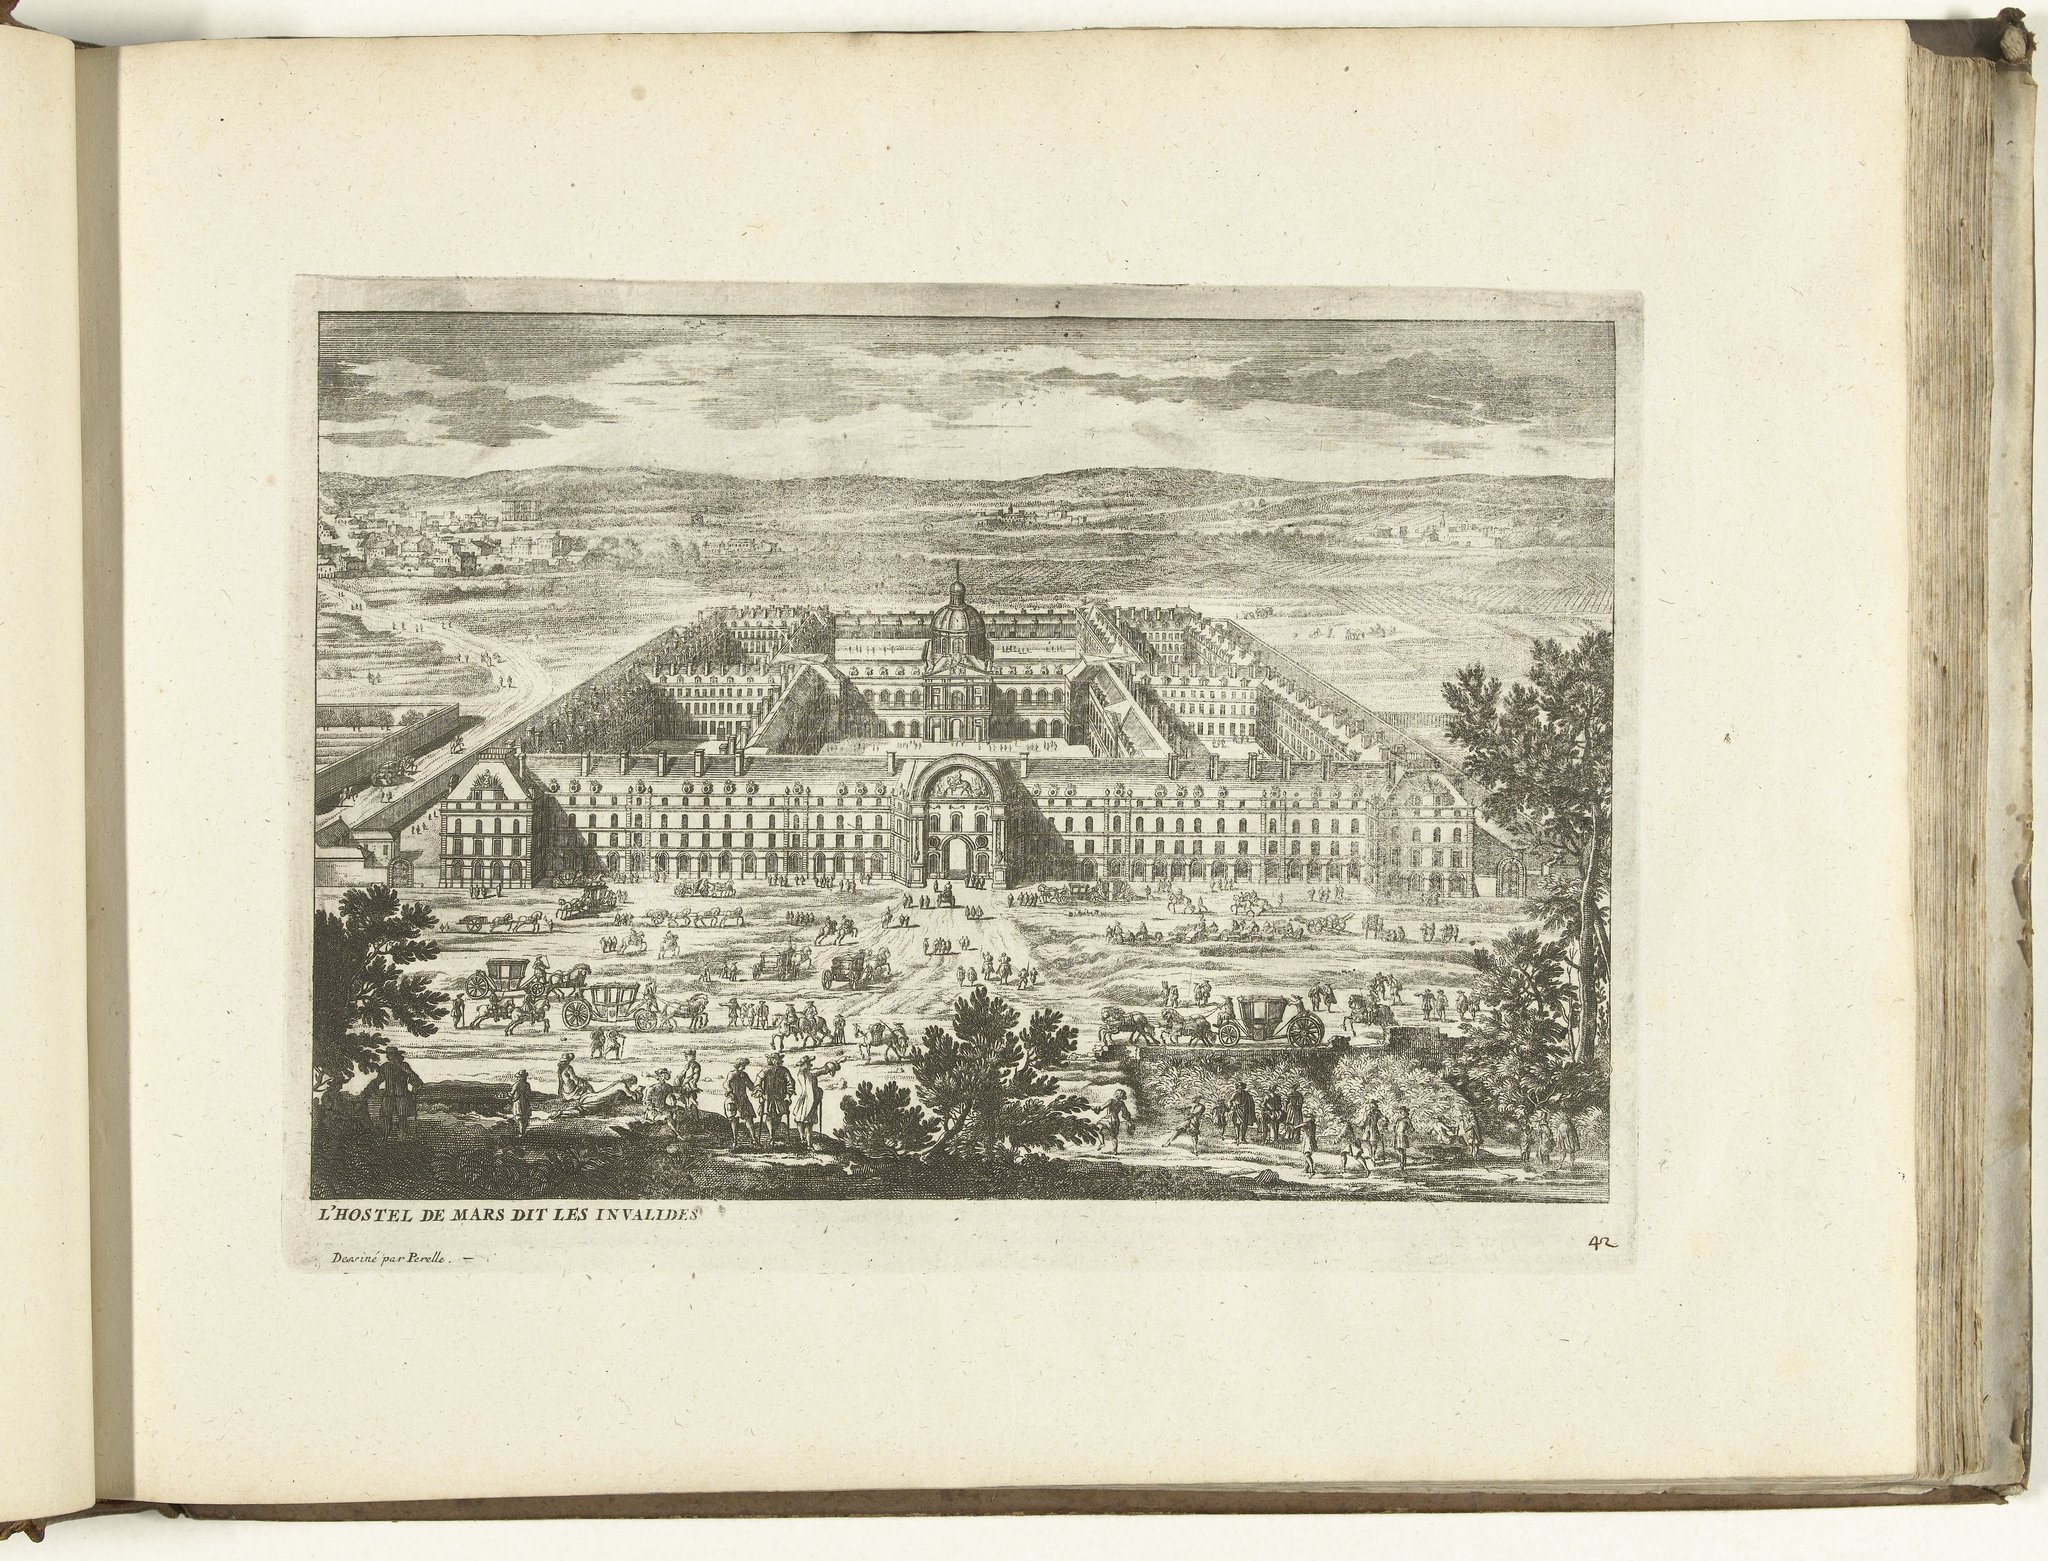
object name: print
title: Les Forces de l'Europe, Asie, Afrique et Amerique (...) Comme aussi les Cartes des Côtes de France et d'Espagne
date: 1726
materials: paper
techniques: etching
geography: leiden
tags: hôtel des invalides, spaanse successieoorlog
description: Gezicht op het Hôtel des Invalides te Parijs. Plaat nr. 42 in deel II van het prentwerk: Les Forces de l'Europe, Asie, Afrique et Amerique ... Comme aussi les Cartes des Côtes de France et d'Espagne uit 1726, dit eerste deel met 238 met de hand genummerde platen van vermaarde sterke steden en vestingen in het kader van de Spaanse Successieoorlog 1701-1713. Voor het merendeel zijn deze platen gekopieerd naar de anonieme Franse platen van vermaarde sterke steden en vestingen: in Les forces de l'Europe en in: Le theatre de la guerre, dans les Pays-Bas, beide oorspronkelijk uitgegeven door Nicolas de Fer te Parijs (1693-1697) in het kader van de Negenjarige Oorlog. Titel en opschriften in het Frans.